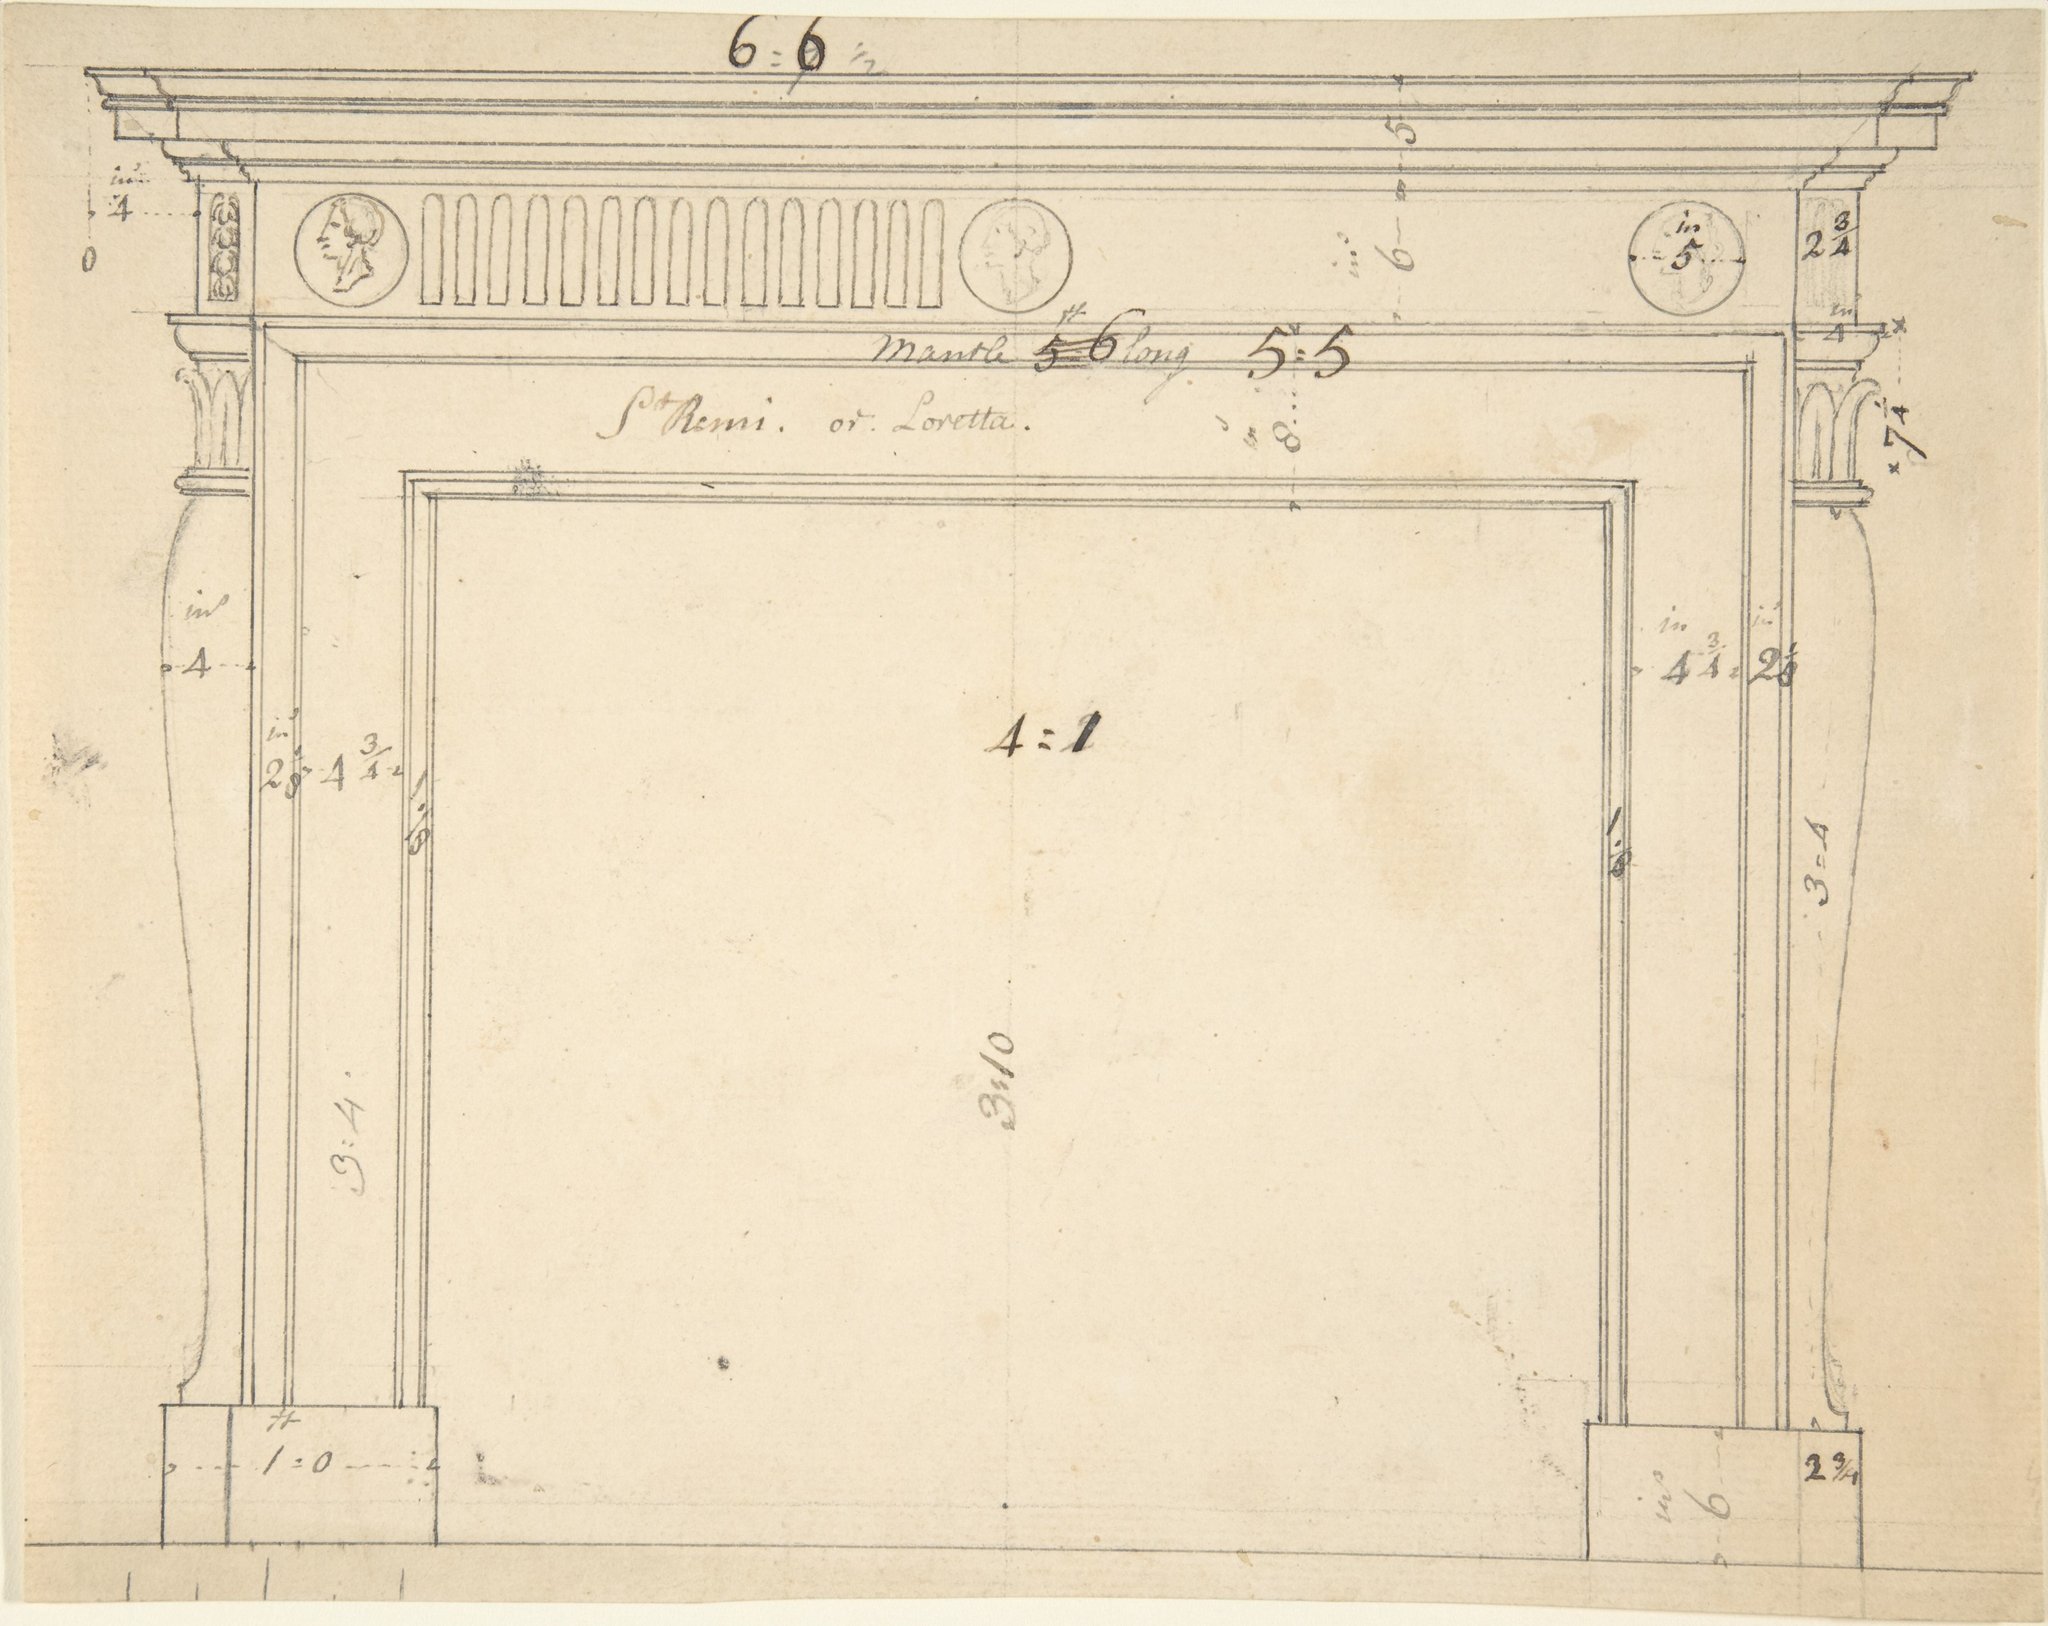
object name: drawing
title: Design for a Chimneypiece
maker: sir william chambers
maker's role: artist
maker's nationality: british, born sweden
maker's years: 1723-1796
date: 1740-1800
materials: ink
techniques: pen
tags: fireplaces